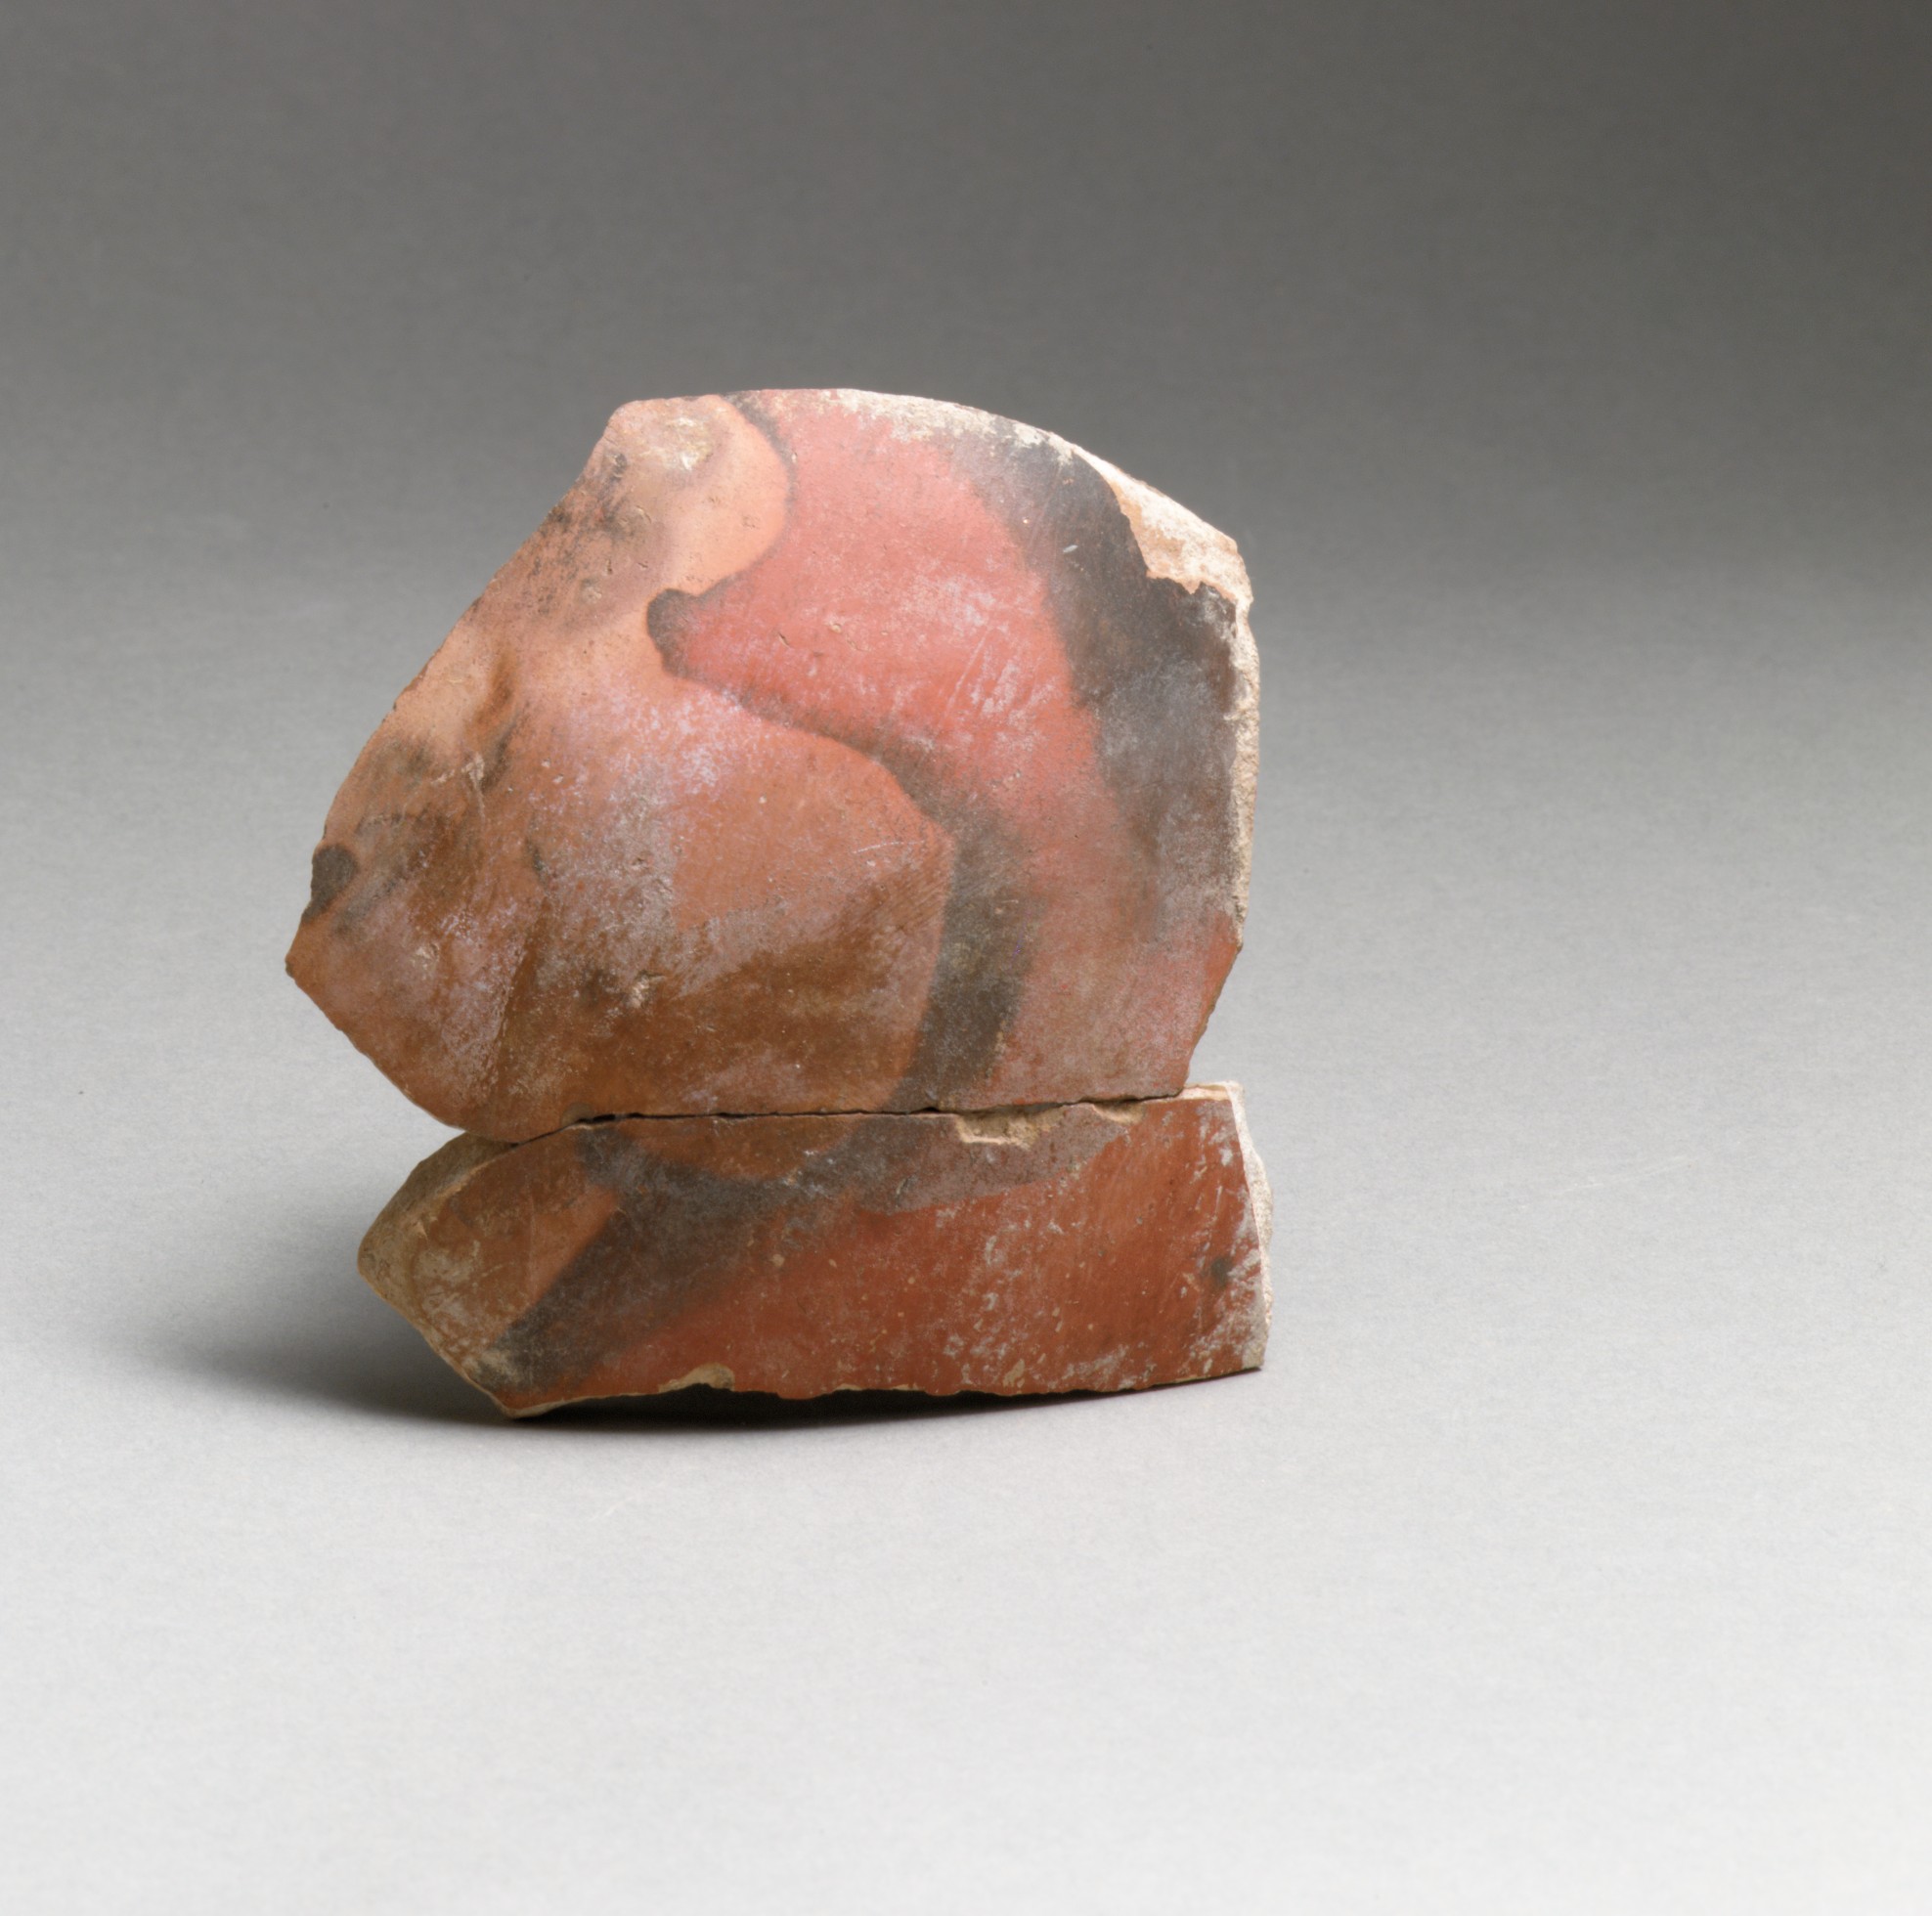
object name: vase fragment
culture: minoan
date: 2600-2000 BCE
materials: terracotta